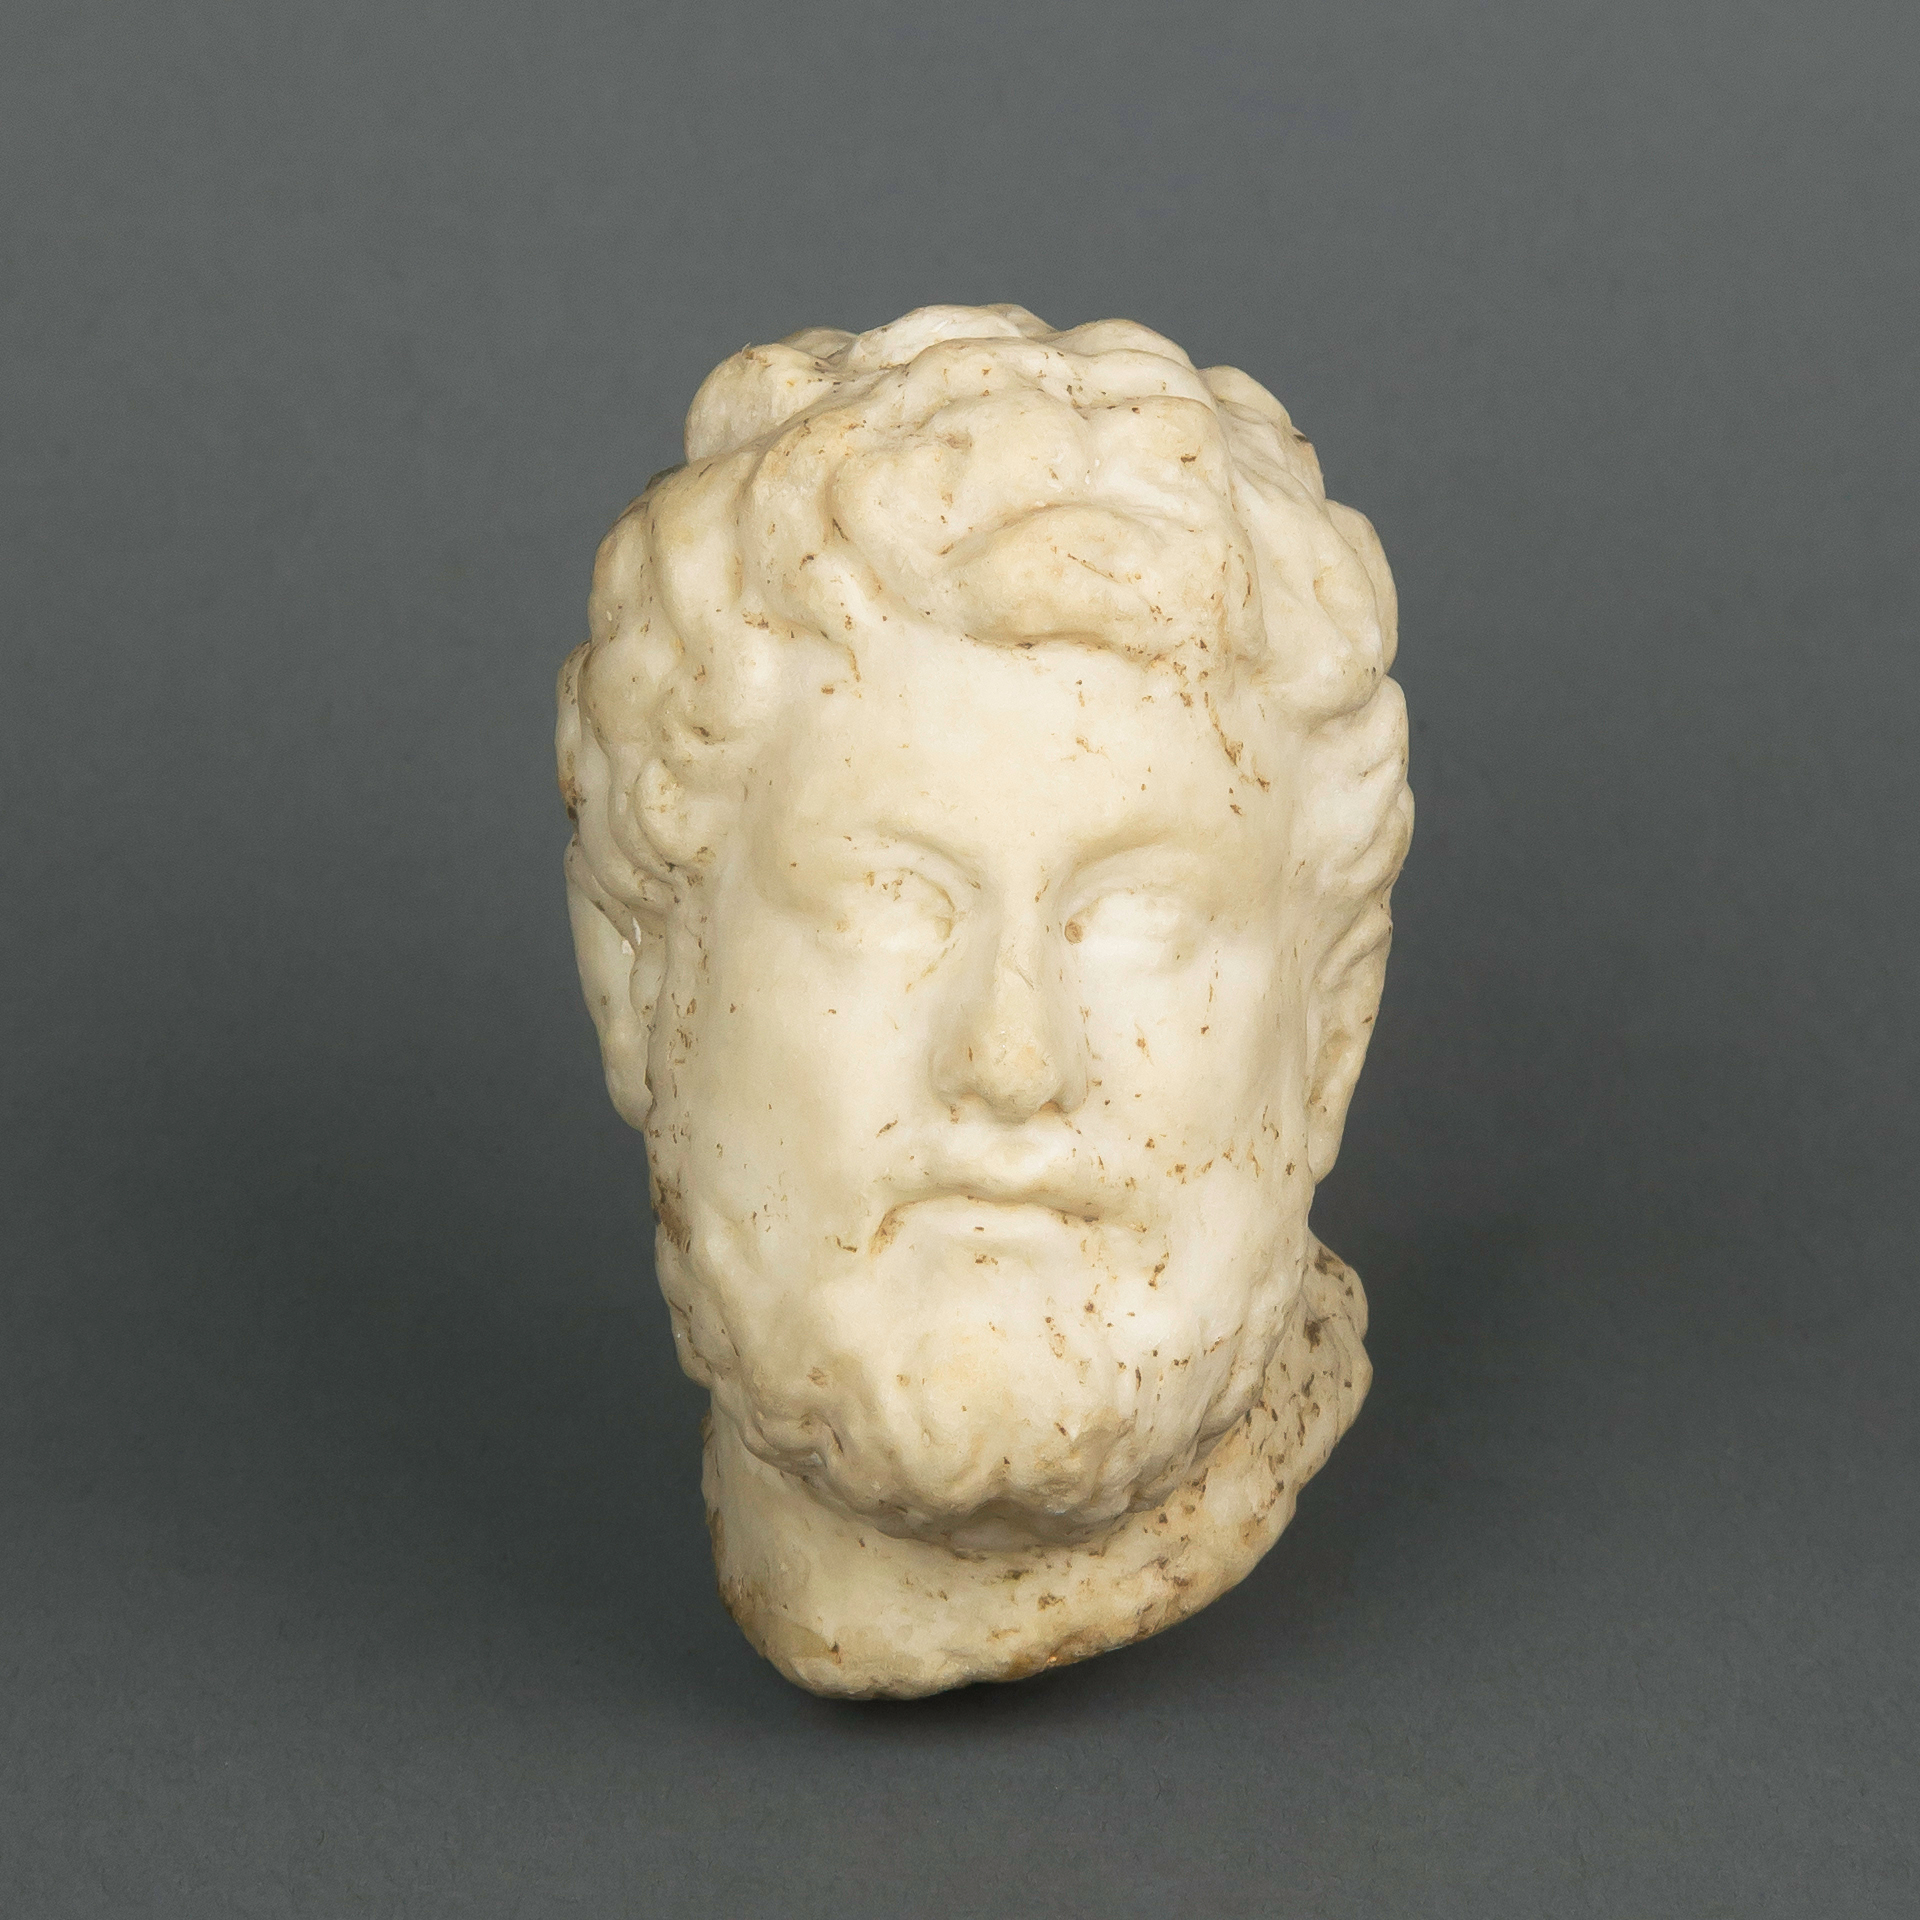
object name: head of a man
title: Marble statuette head of a bearded man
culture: roman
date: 101-200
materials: marble